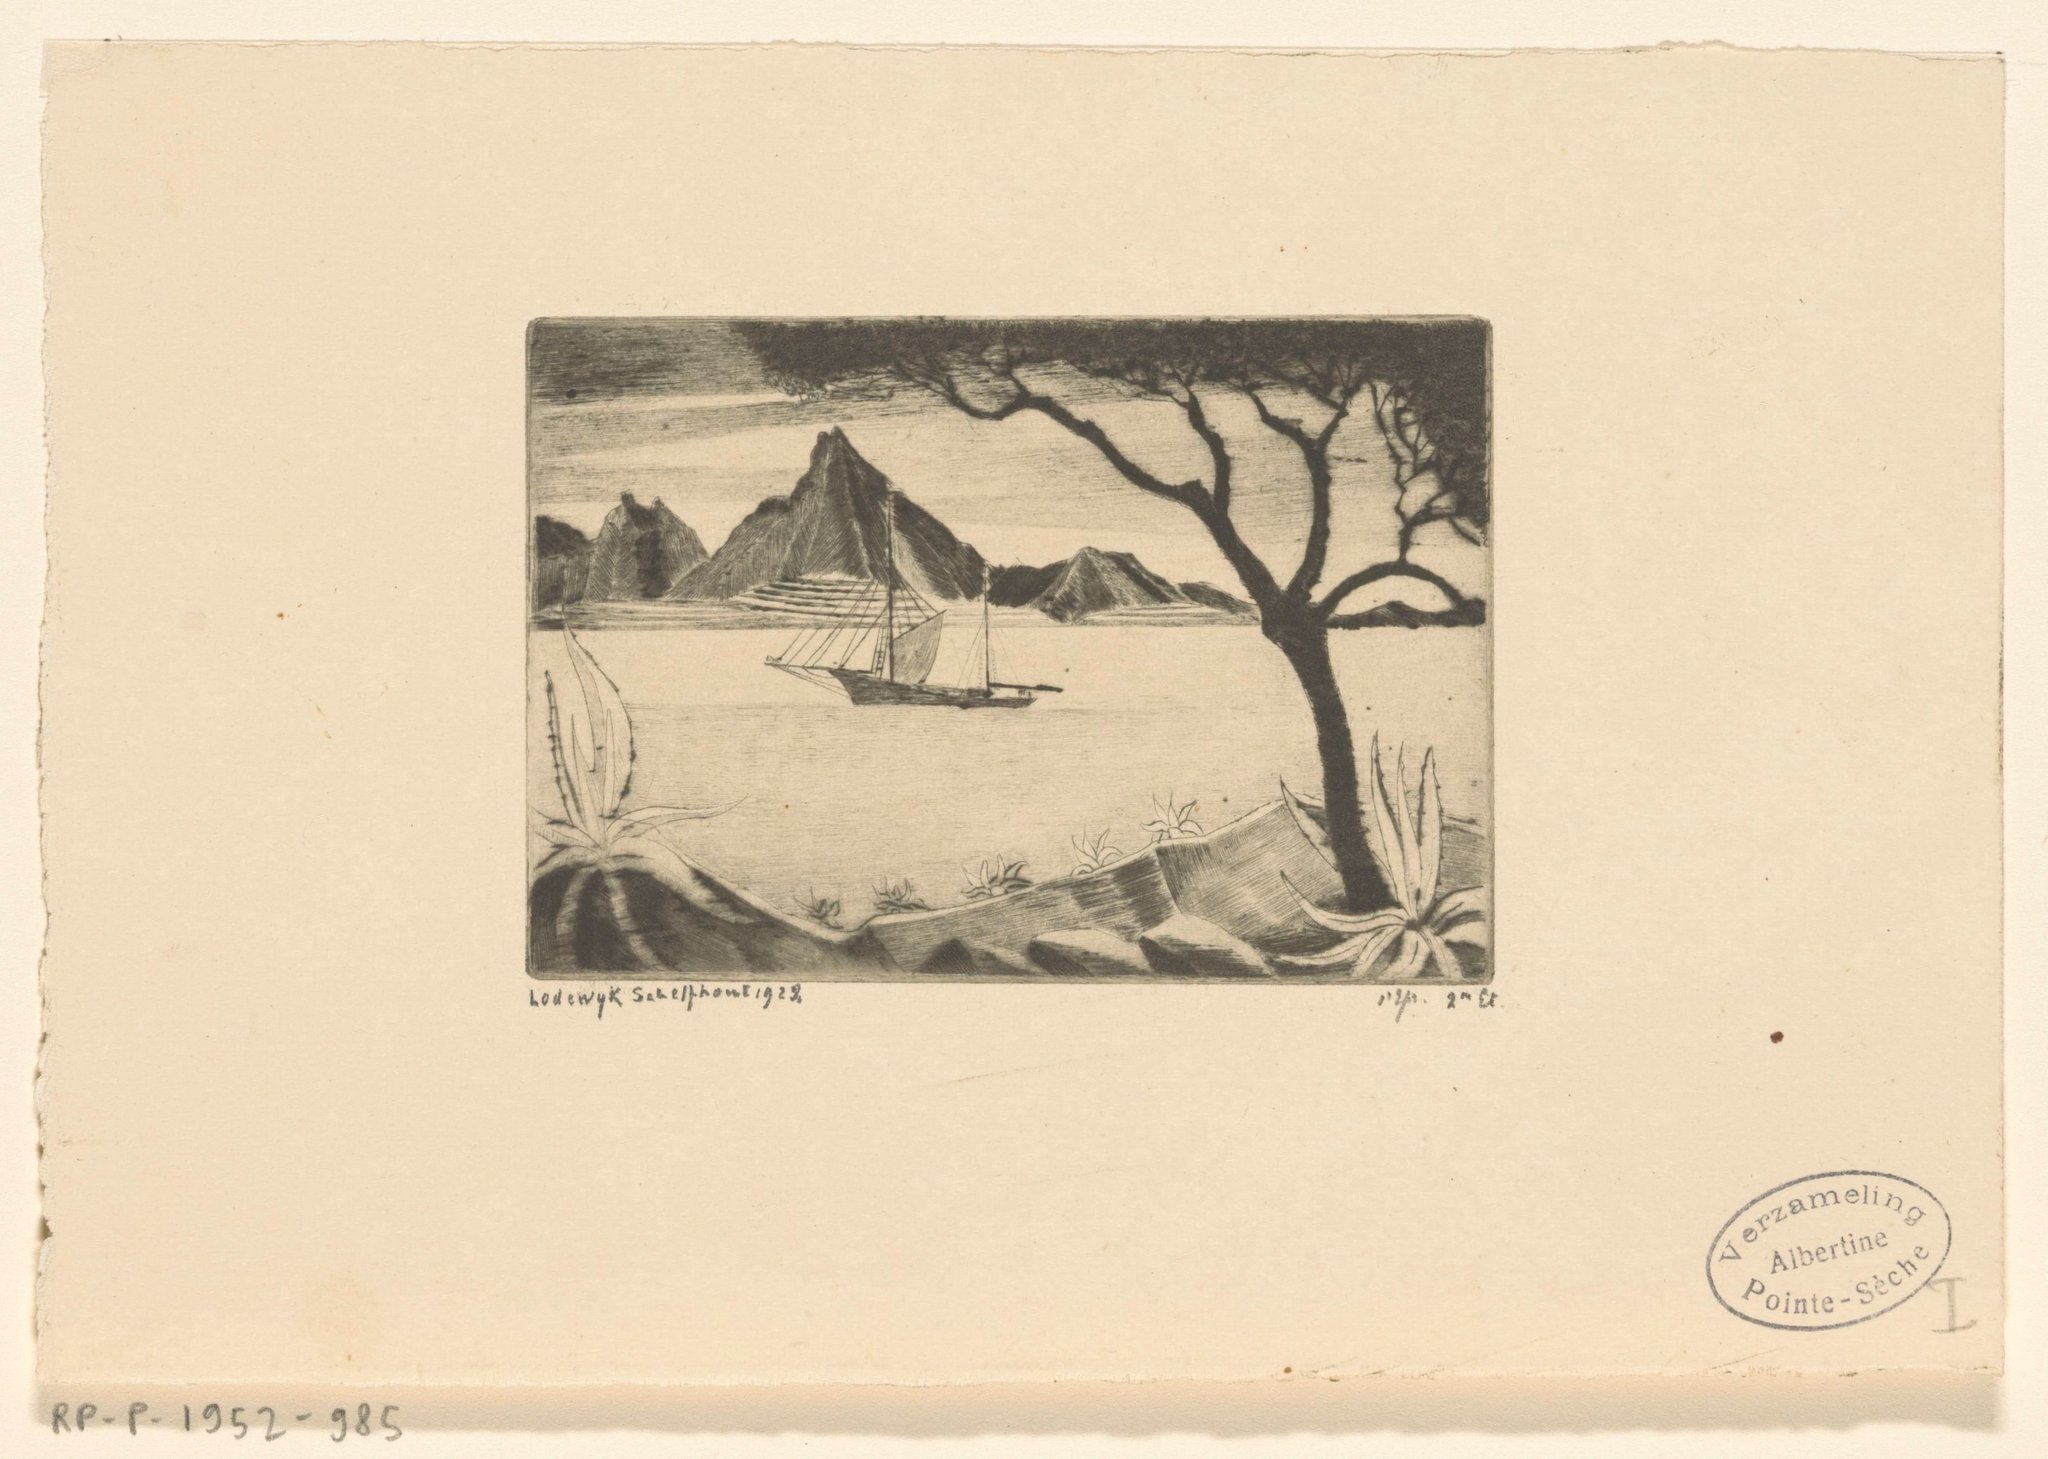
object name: print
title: Le Bâteau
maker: lodewijk schelfhout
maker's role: draughtsman, print maker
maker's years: 1881-1943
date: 1922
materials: paper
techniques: drypoint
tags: sailing-ship, sailing-boat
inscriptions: collector's mark: Lugt 2760, collector's mark: Lugt 2228, collector's mark: Lugt 5i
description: Op de voorgrond een boom, op de achtergrond bergen.